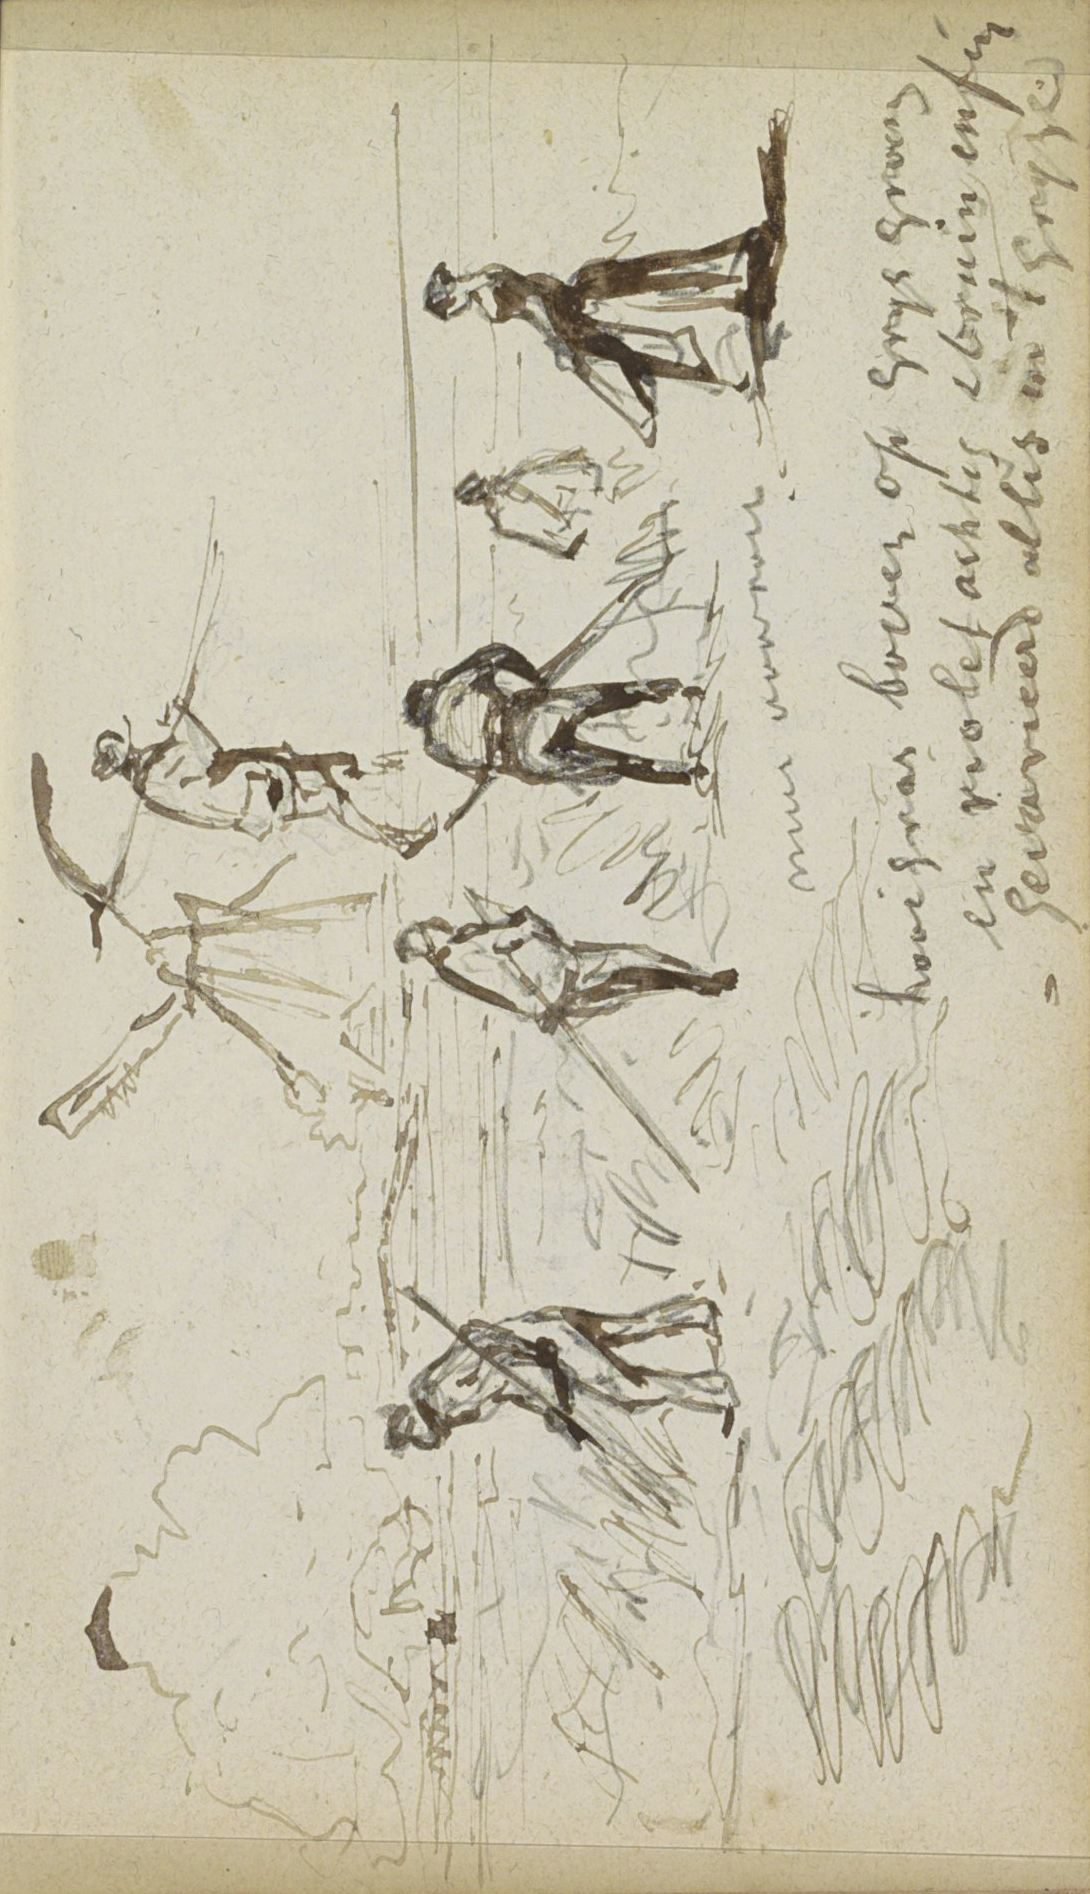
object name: sketchbook leaf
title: Weiland met mannen die hooi maaien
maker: johannes tavenraat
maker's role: draughtsman, painter, print maker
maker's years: 1809-1881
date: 1862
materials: ink, paper, pencil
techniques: pen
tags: agricultural products and by-products: hay (+ labourers ~ crafts, industries, agriculture), windmill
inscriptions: kleurnotitie, handgeschreven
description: Op de achtergrond een molen. Een vrouw kijkt toe hoe het hooi wordt gemaaid. Blad 67 recto uit een schetsboek met 88 bladen.